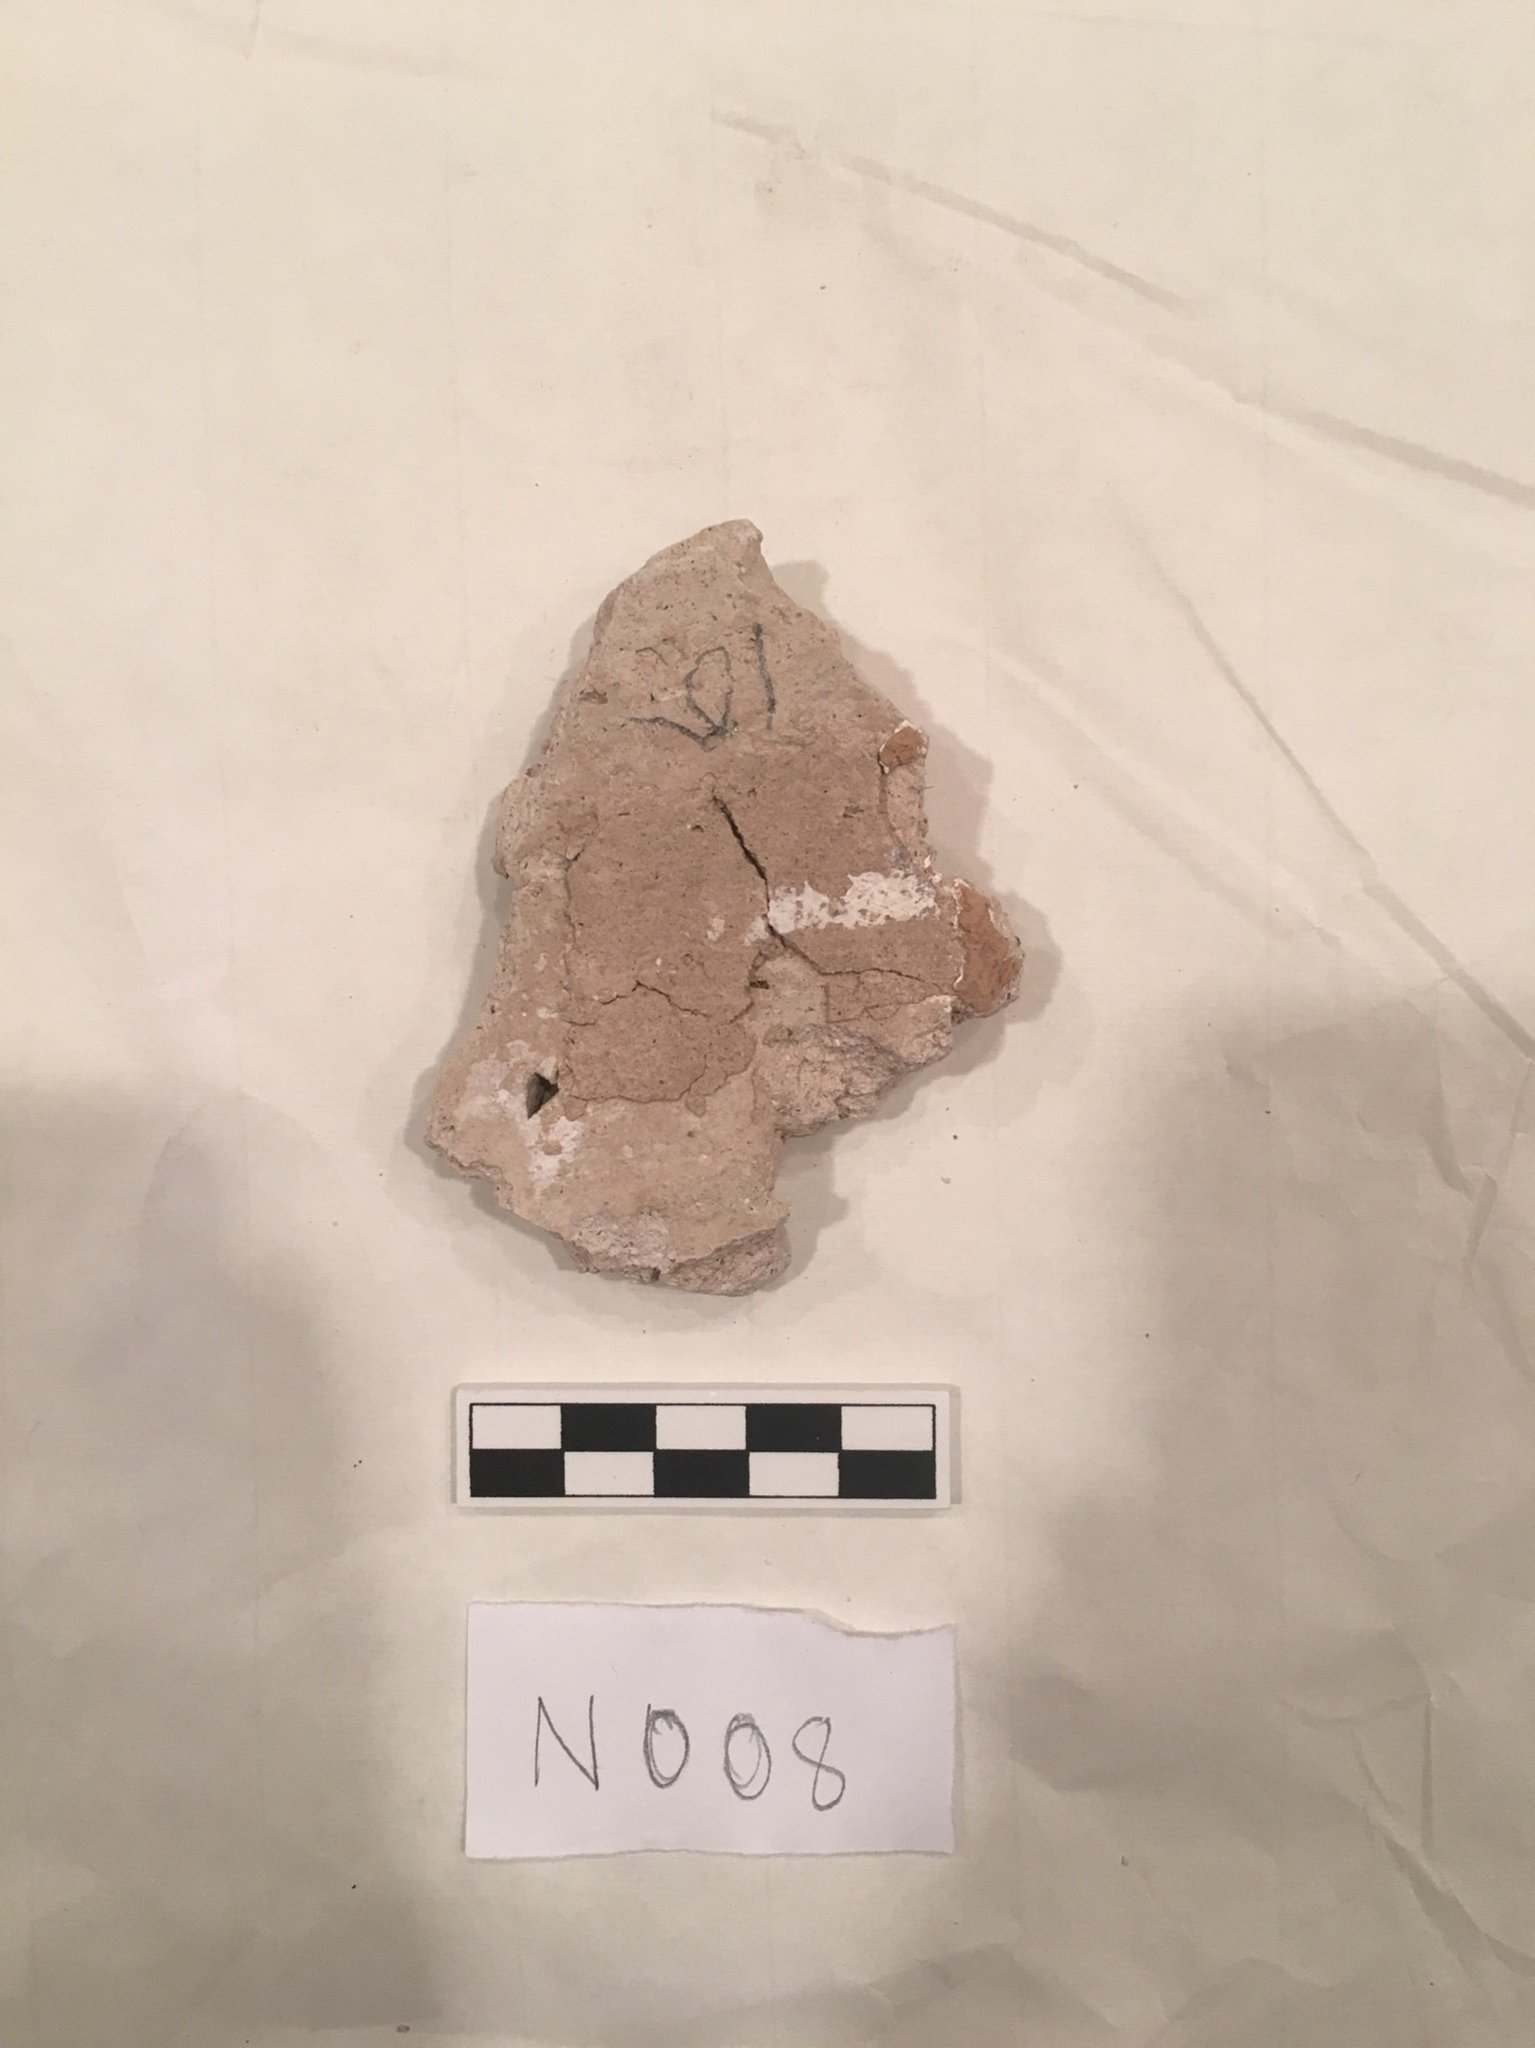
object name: fragment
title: Stucco Fragment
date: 701-1200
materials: plaster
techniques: carving, painting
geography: iran